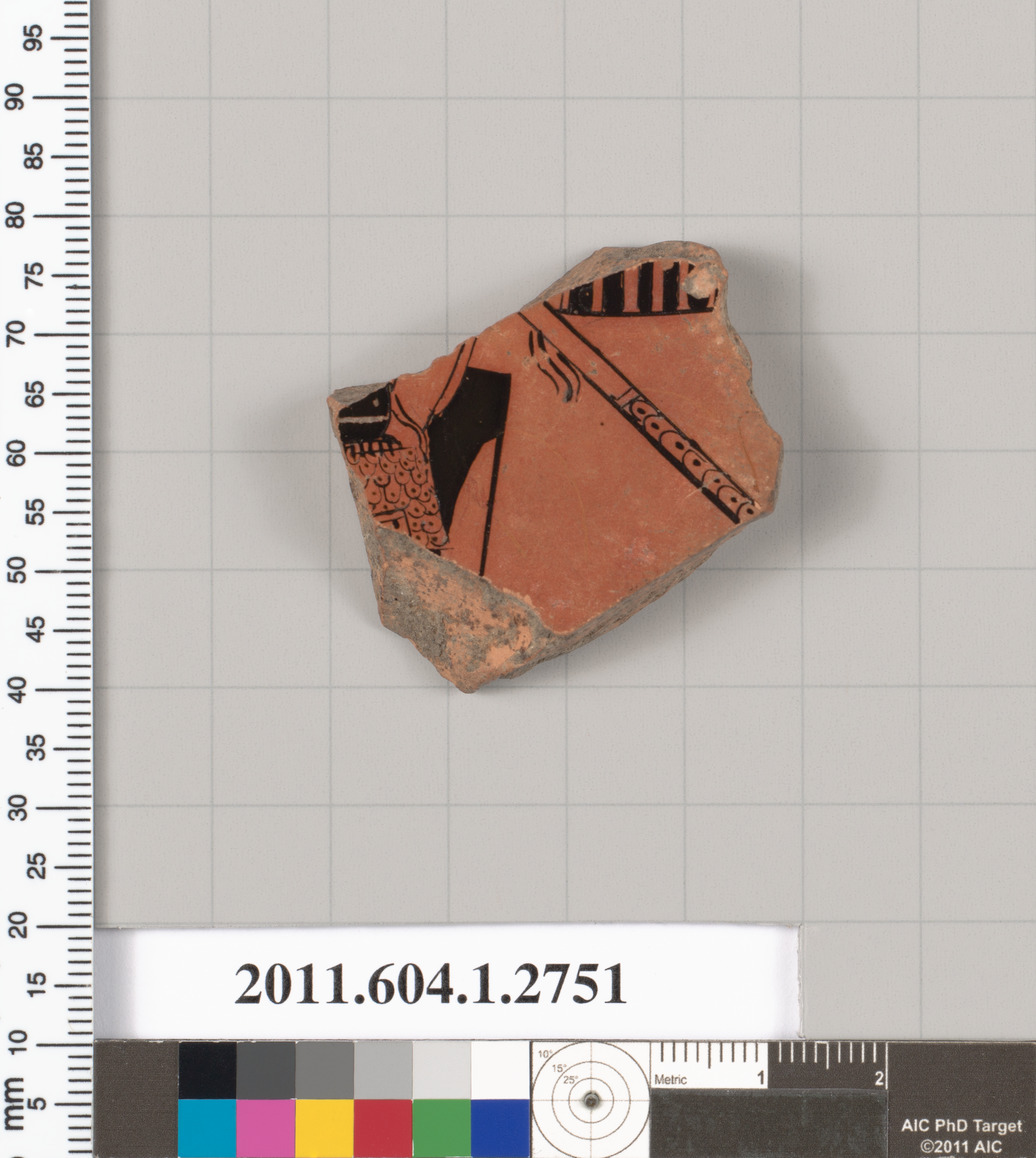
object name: kylix fragment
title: Terracotta fragment of a kylix (drinking cup)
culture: greek, attic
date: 480-470 BCE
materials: terracotta